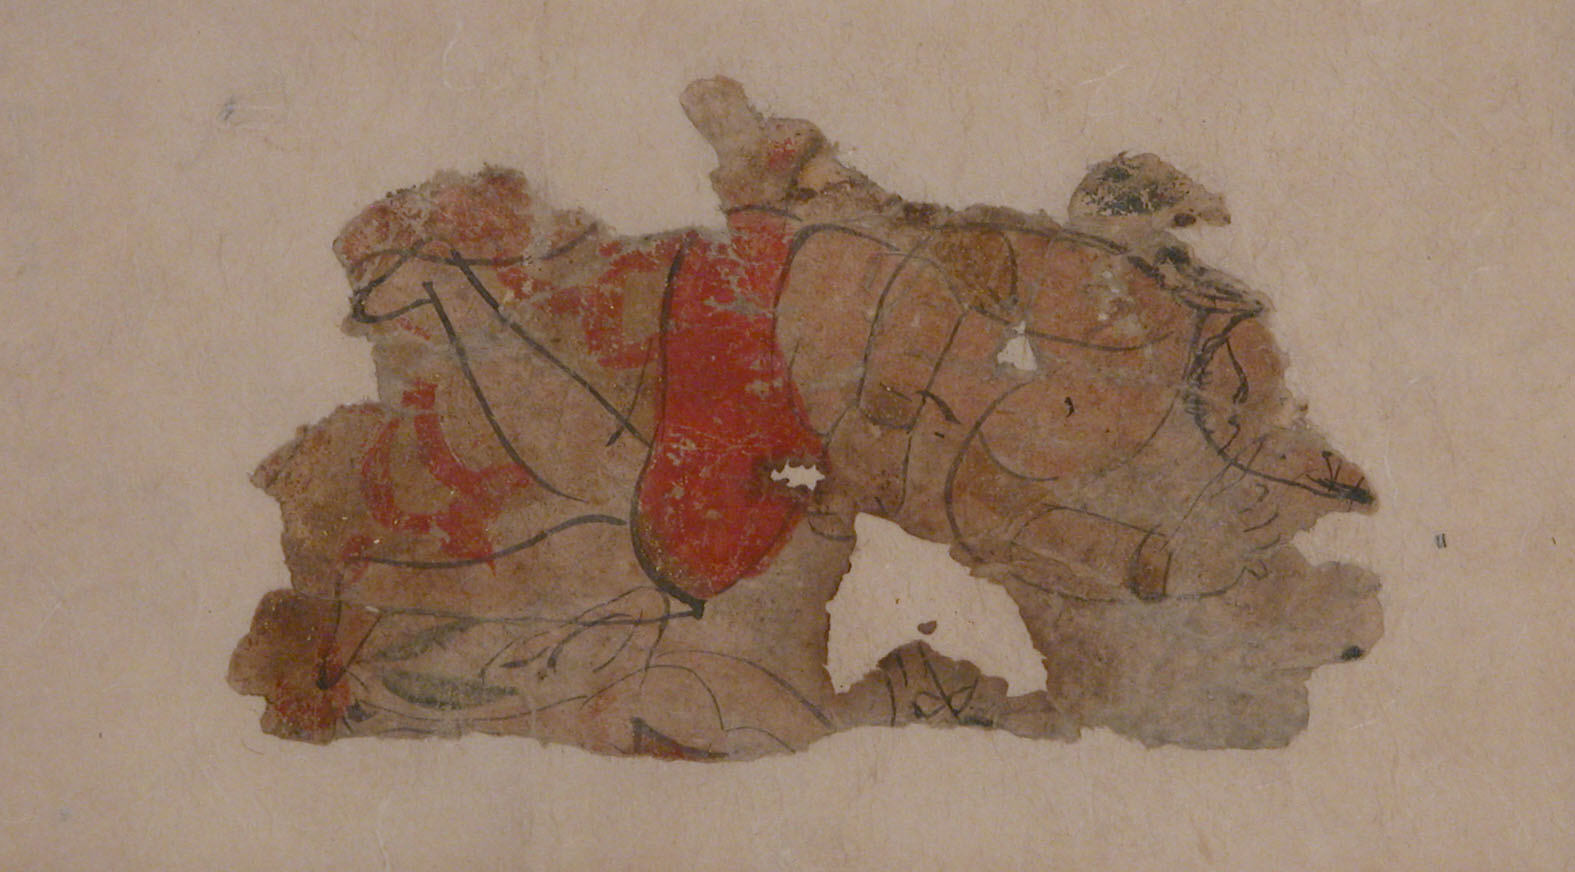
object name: illustrated single work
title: Figure of a Man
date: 1201-1300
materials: ink, paper, watercolor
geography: egypt or iraq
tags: men